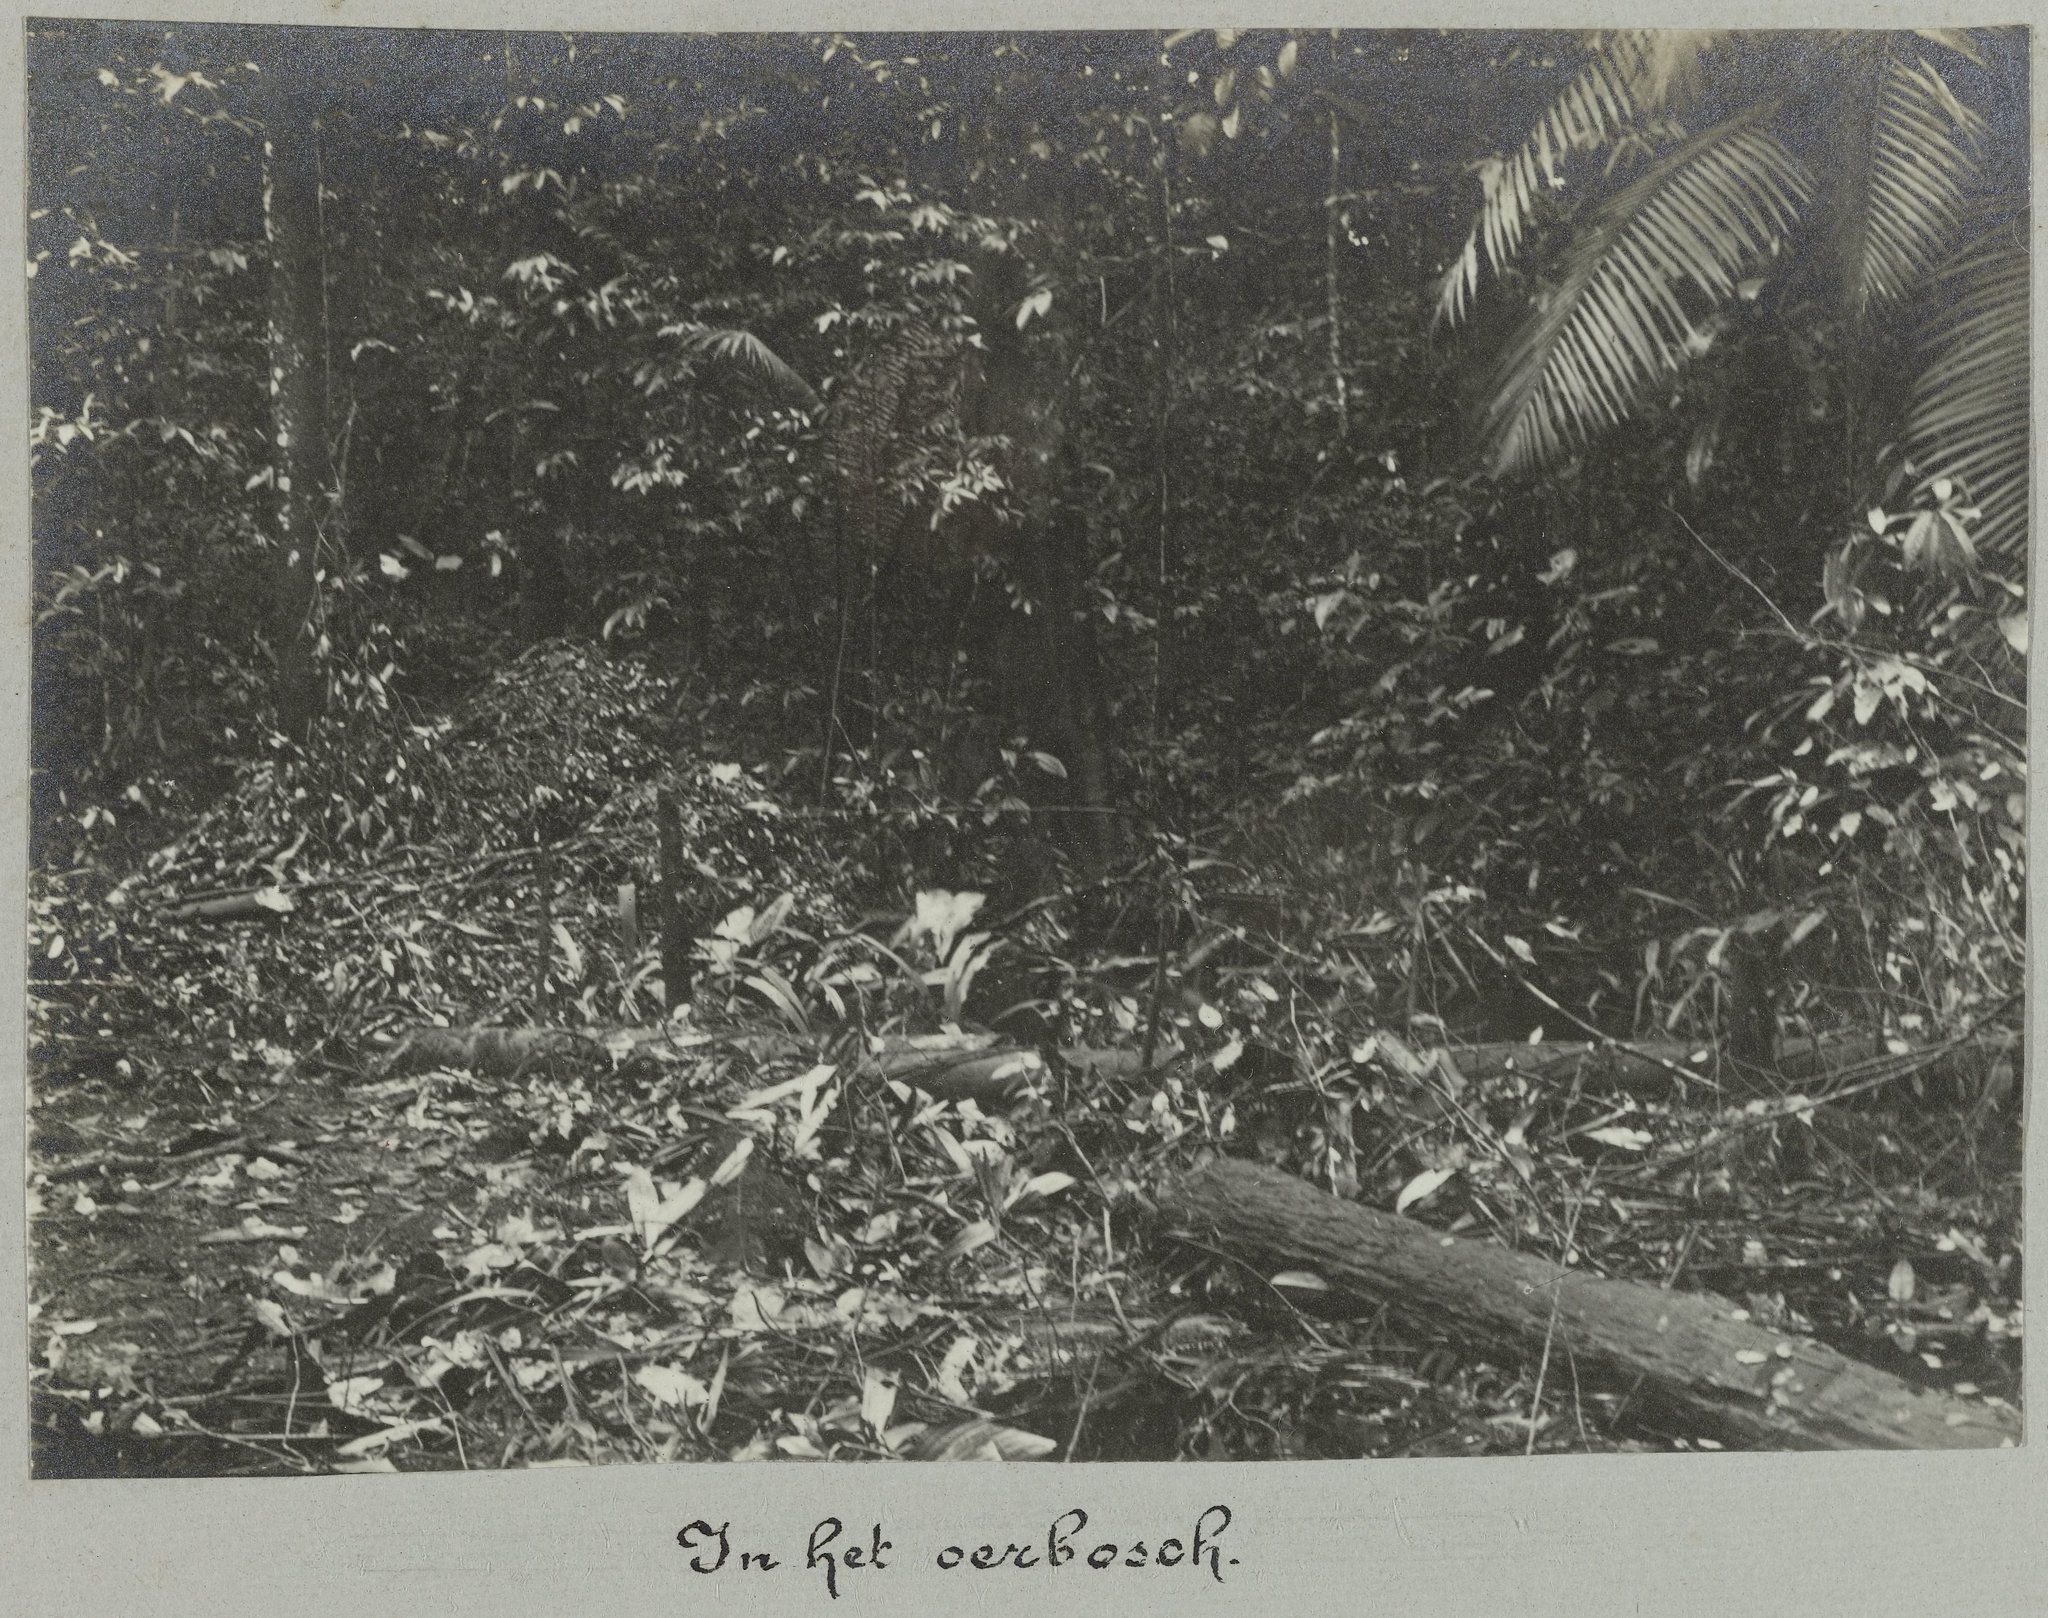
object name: photograph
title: In het oerbosch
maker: hendrik doijer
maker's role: engineer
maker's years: 1863-1925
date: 1903-1910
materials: photographic support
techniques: gelatin silver print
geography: suriname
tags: suriname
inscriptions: inscription: ‘5. / In het oerbosch’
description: Bomen en planten in het Surinaamse oerbos. Onderdeel van het fotoalbum Souvenir de Voyage (deel 1), over het leven van de familie Doijer in en rond de plantage Ma Retraite in Suriname in de jaren 1903-1910.